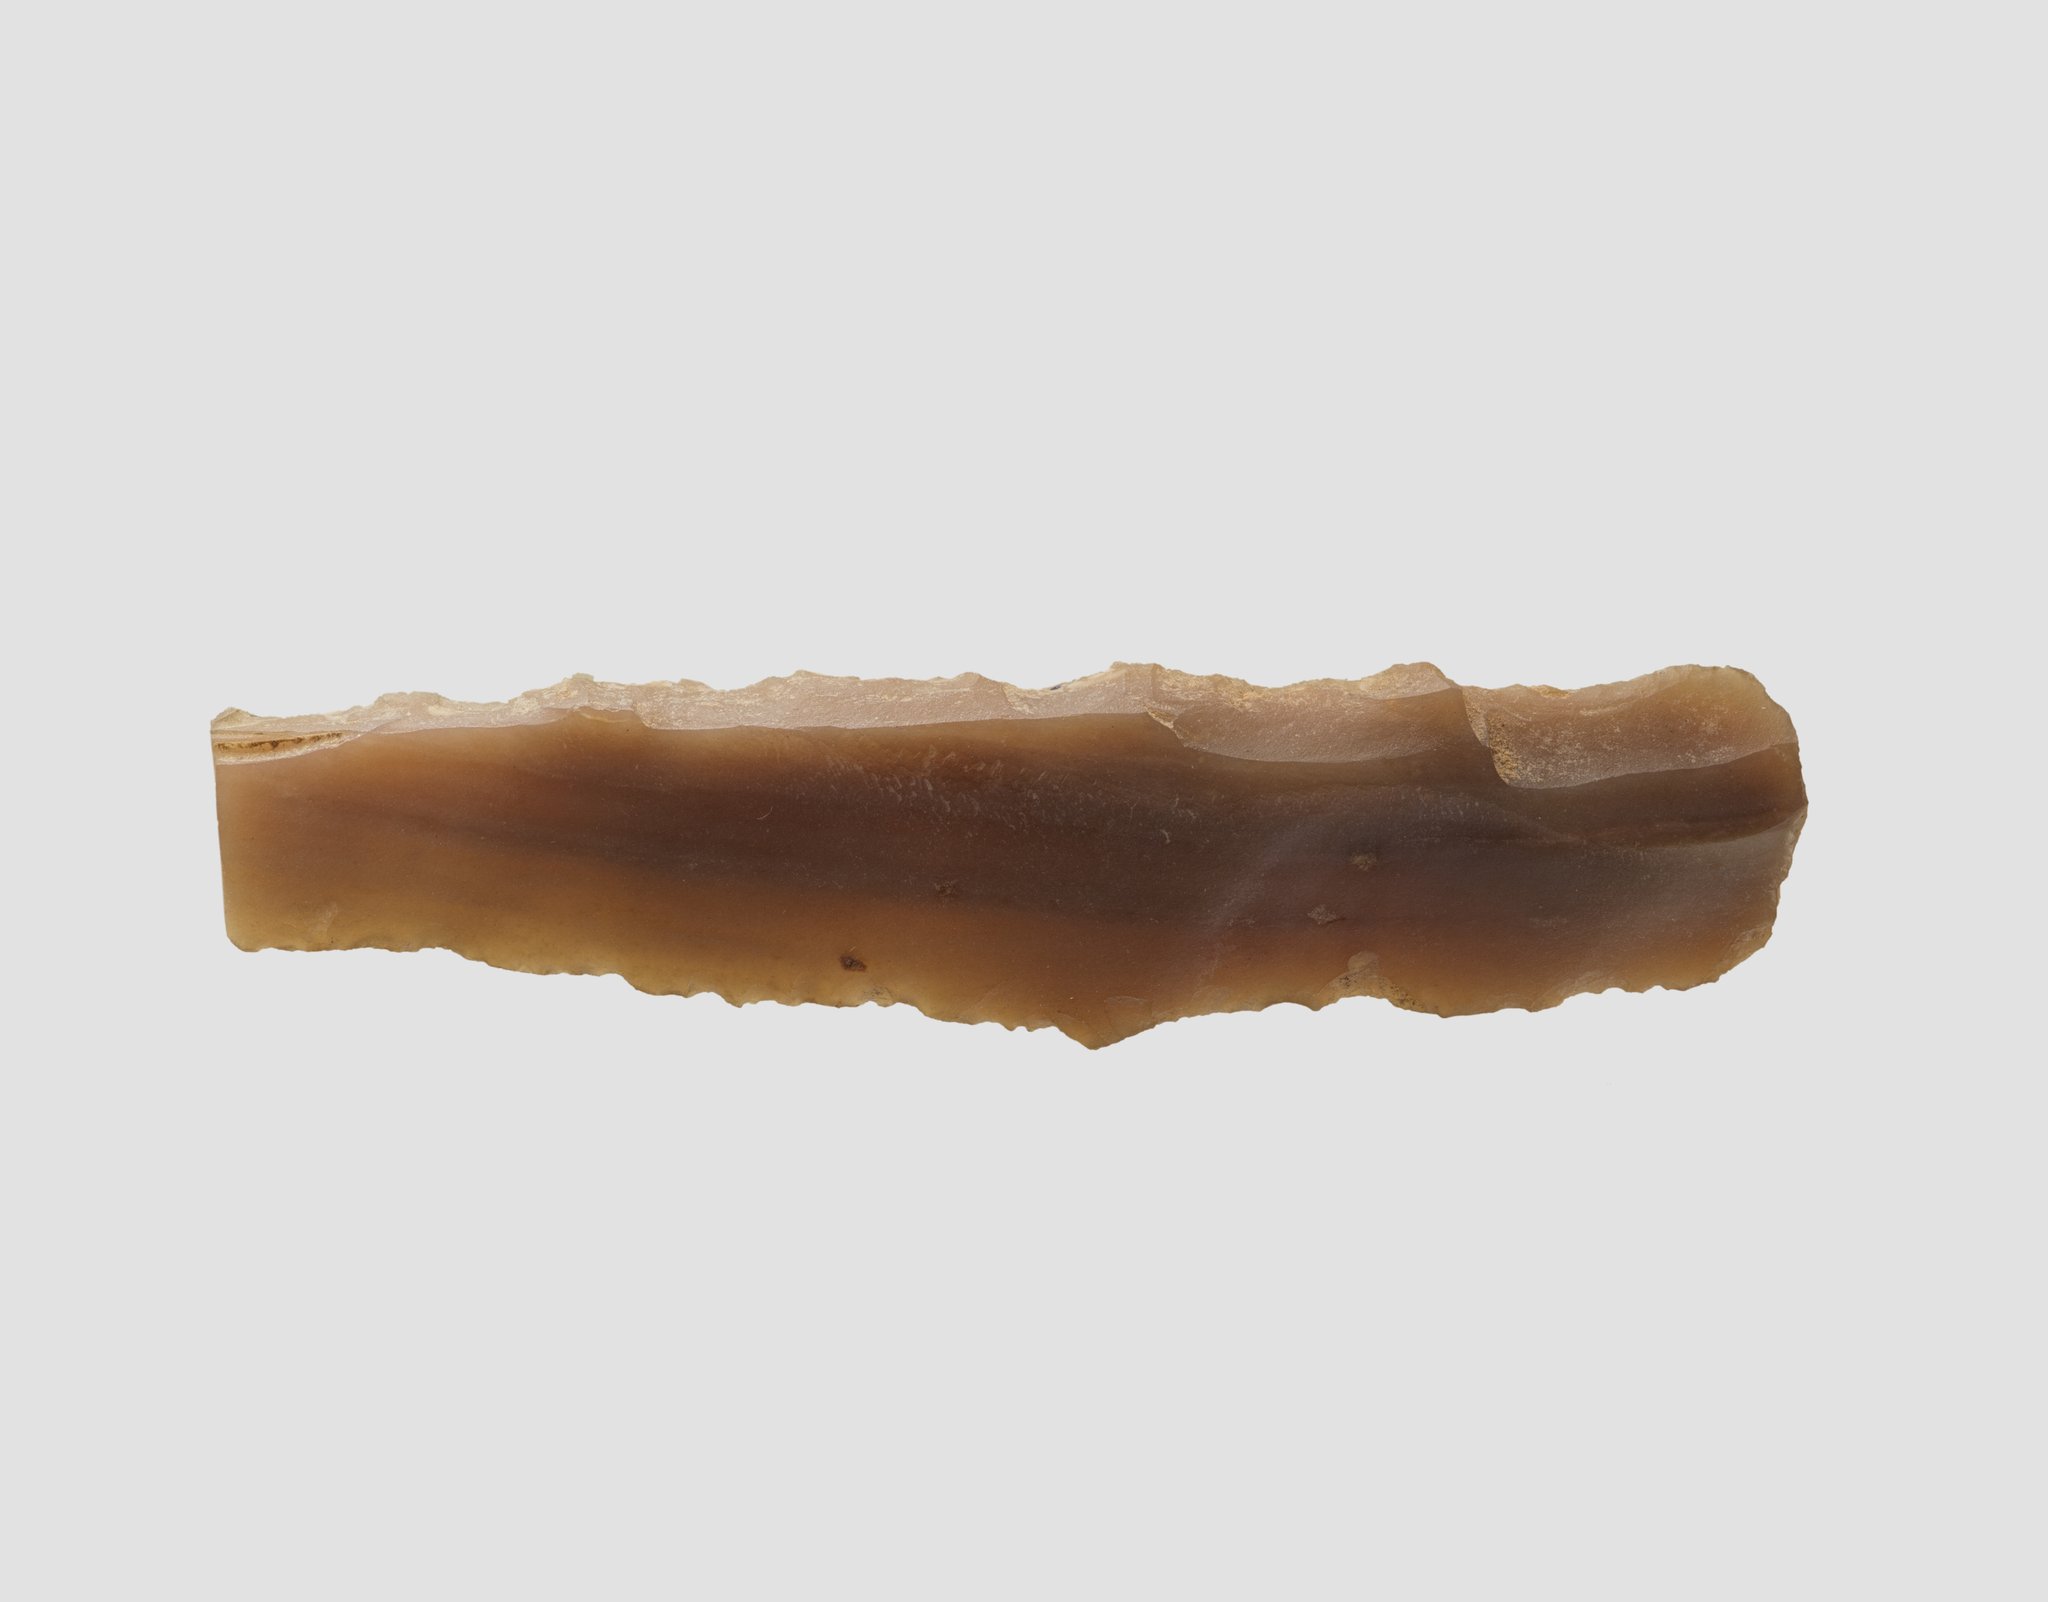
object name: knife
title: Blade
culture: ghassulian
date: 4600-3600 BCE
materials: stone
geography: levant